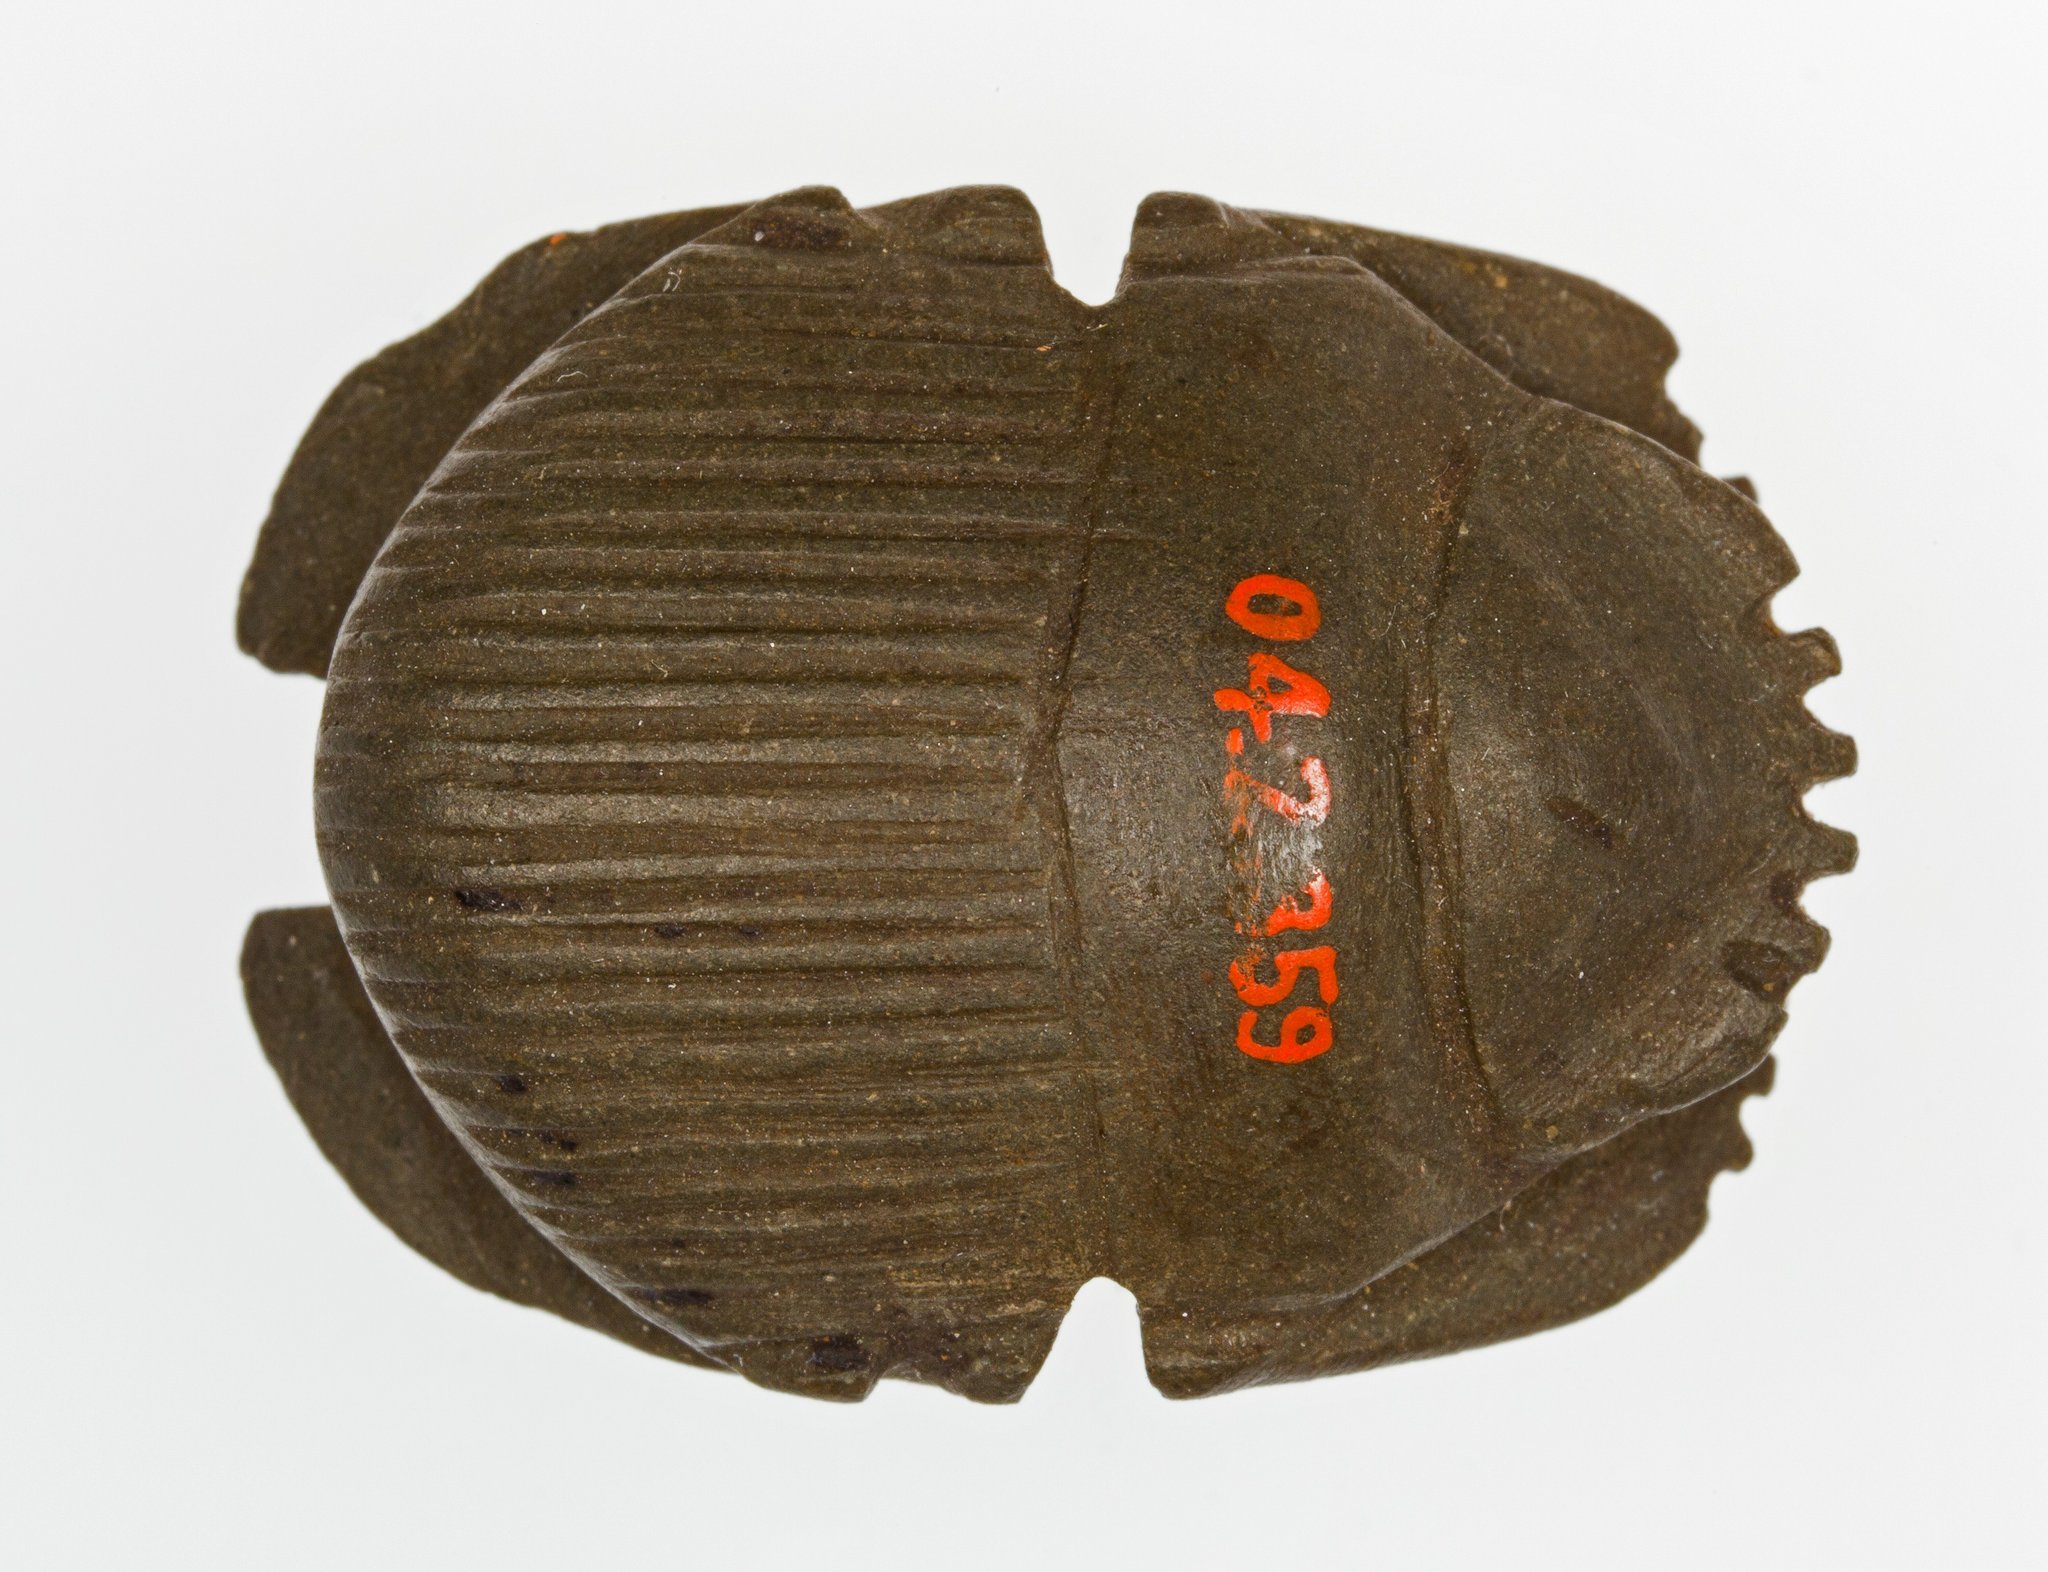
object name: scarab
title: Uninscribed scarab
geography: egypt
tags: scarabs